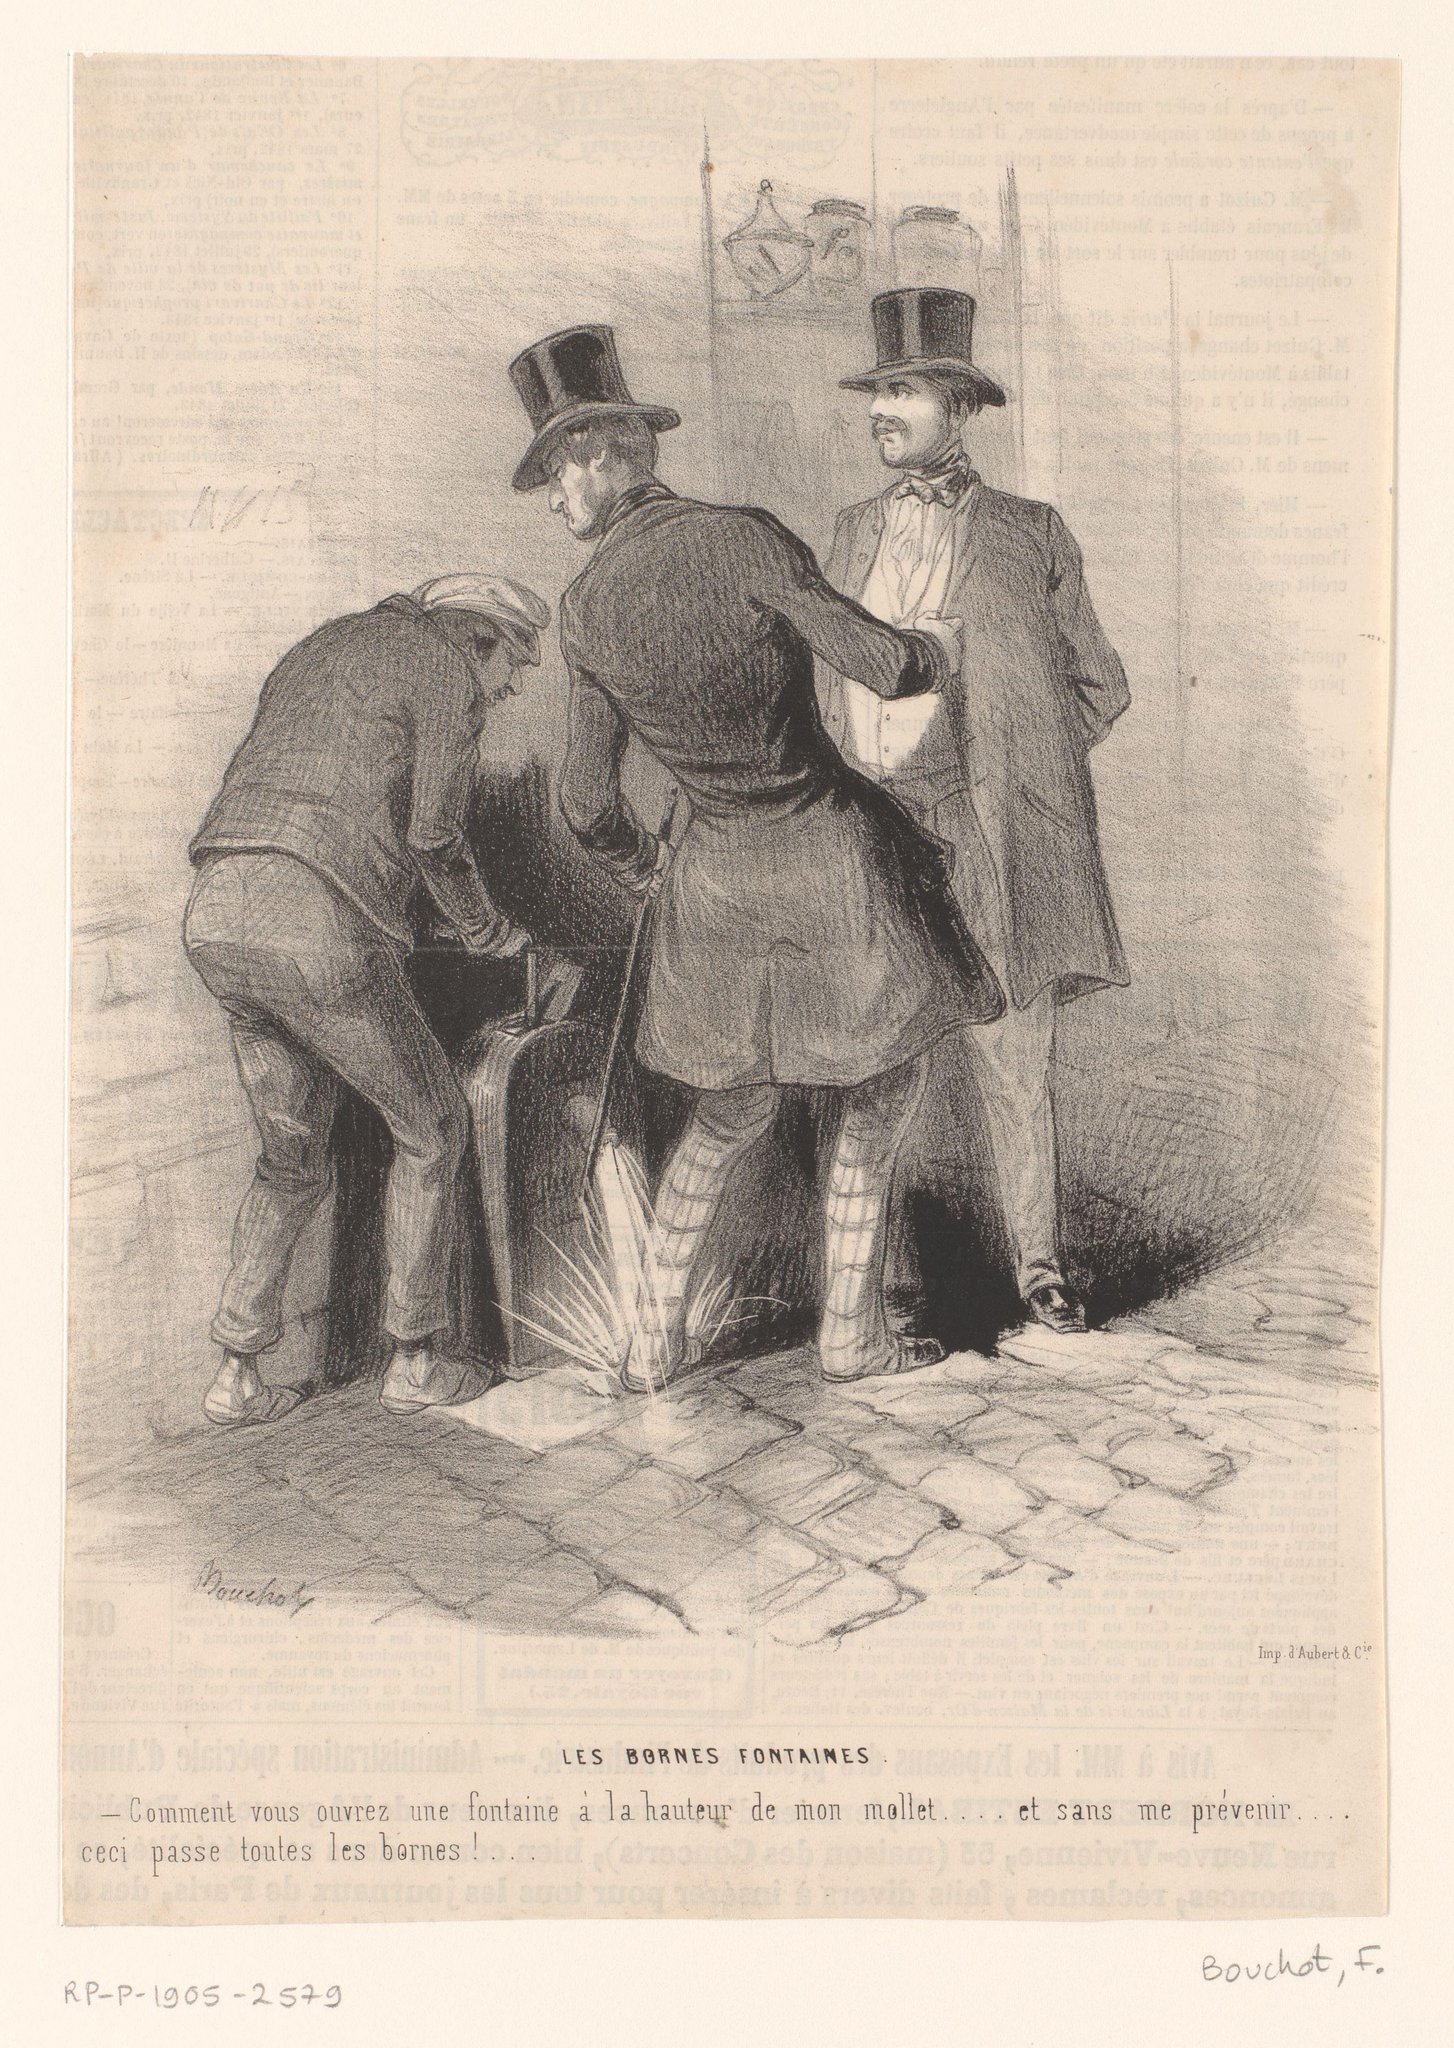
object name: print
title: Man spettert water op de broek van een heer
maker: frédéric bouchot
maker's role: draughtsman, print maker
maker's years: 1798-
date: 1844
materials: paper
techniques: lithograph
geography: paris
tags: contrast between important and unimportant people; the inferior before the superior, the weak before the mighty, utilitarian, public pump or water fountain, paris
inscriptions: collector's mark: Lugt 2228a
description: Een deftig geklede man scheldt op een arbeider, die een pomp opent en het water op de kuit van de heer laat spetteren.